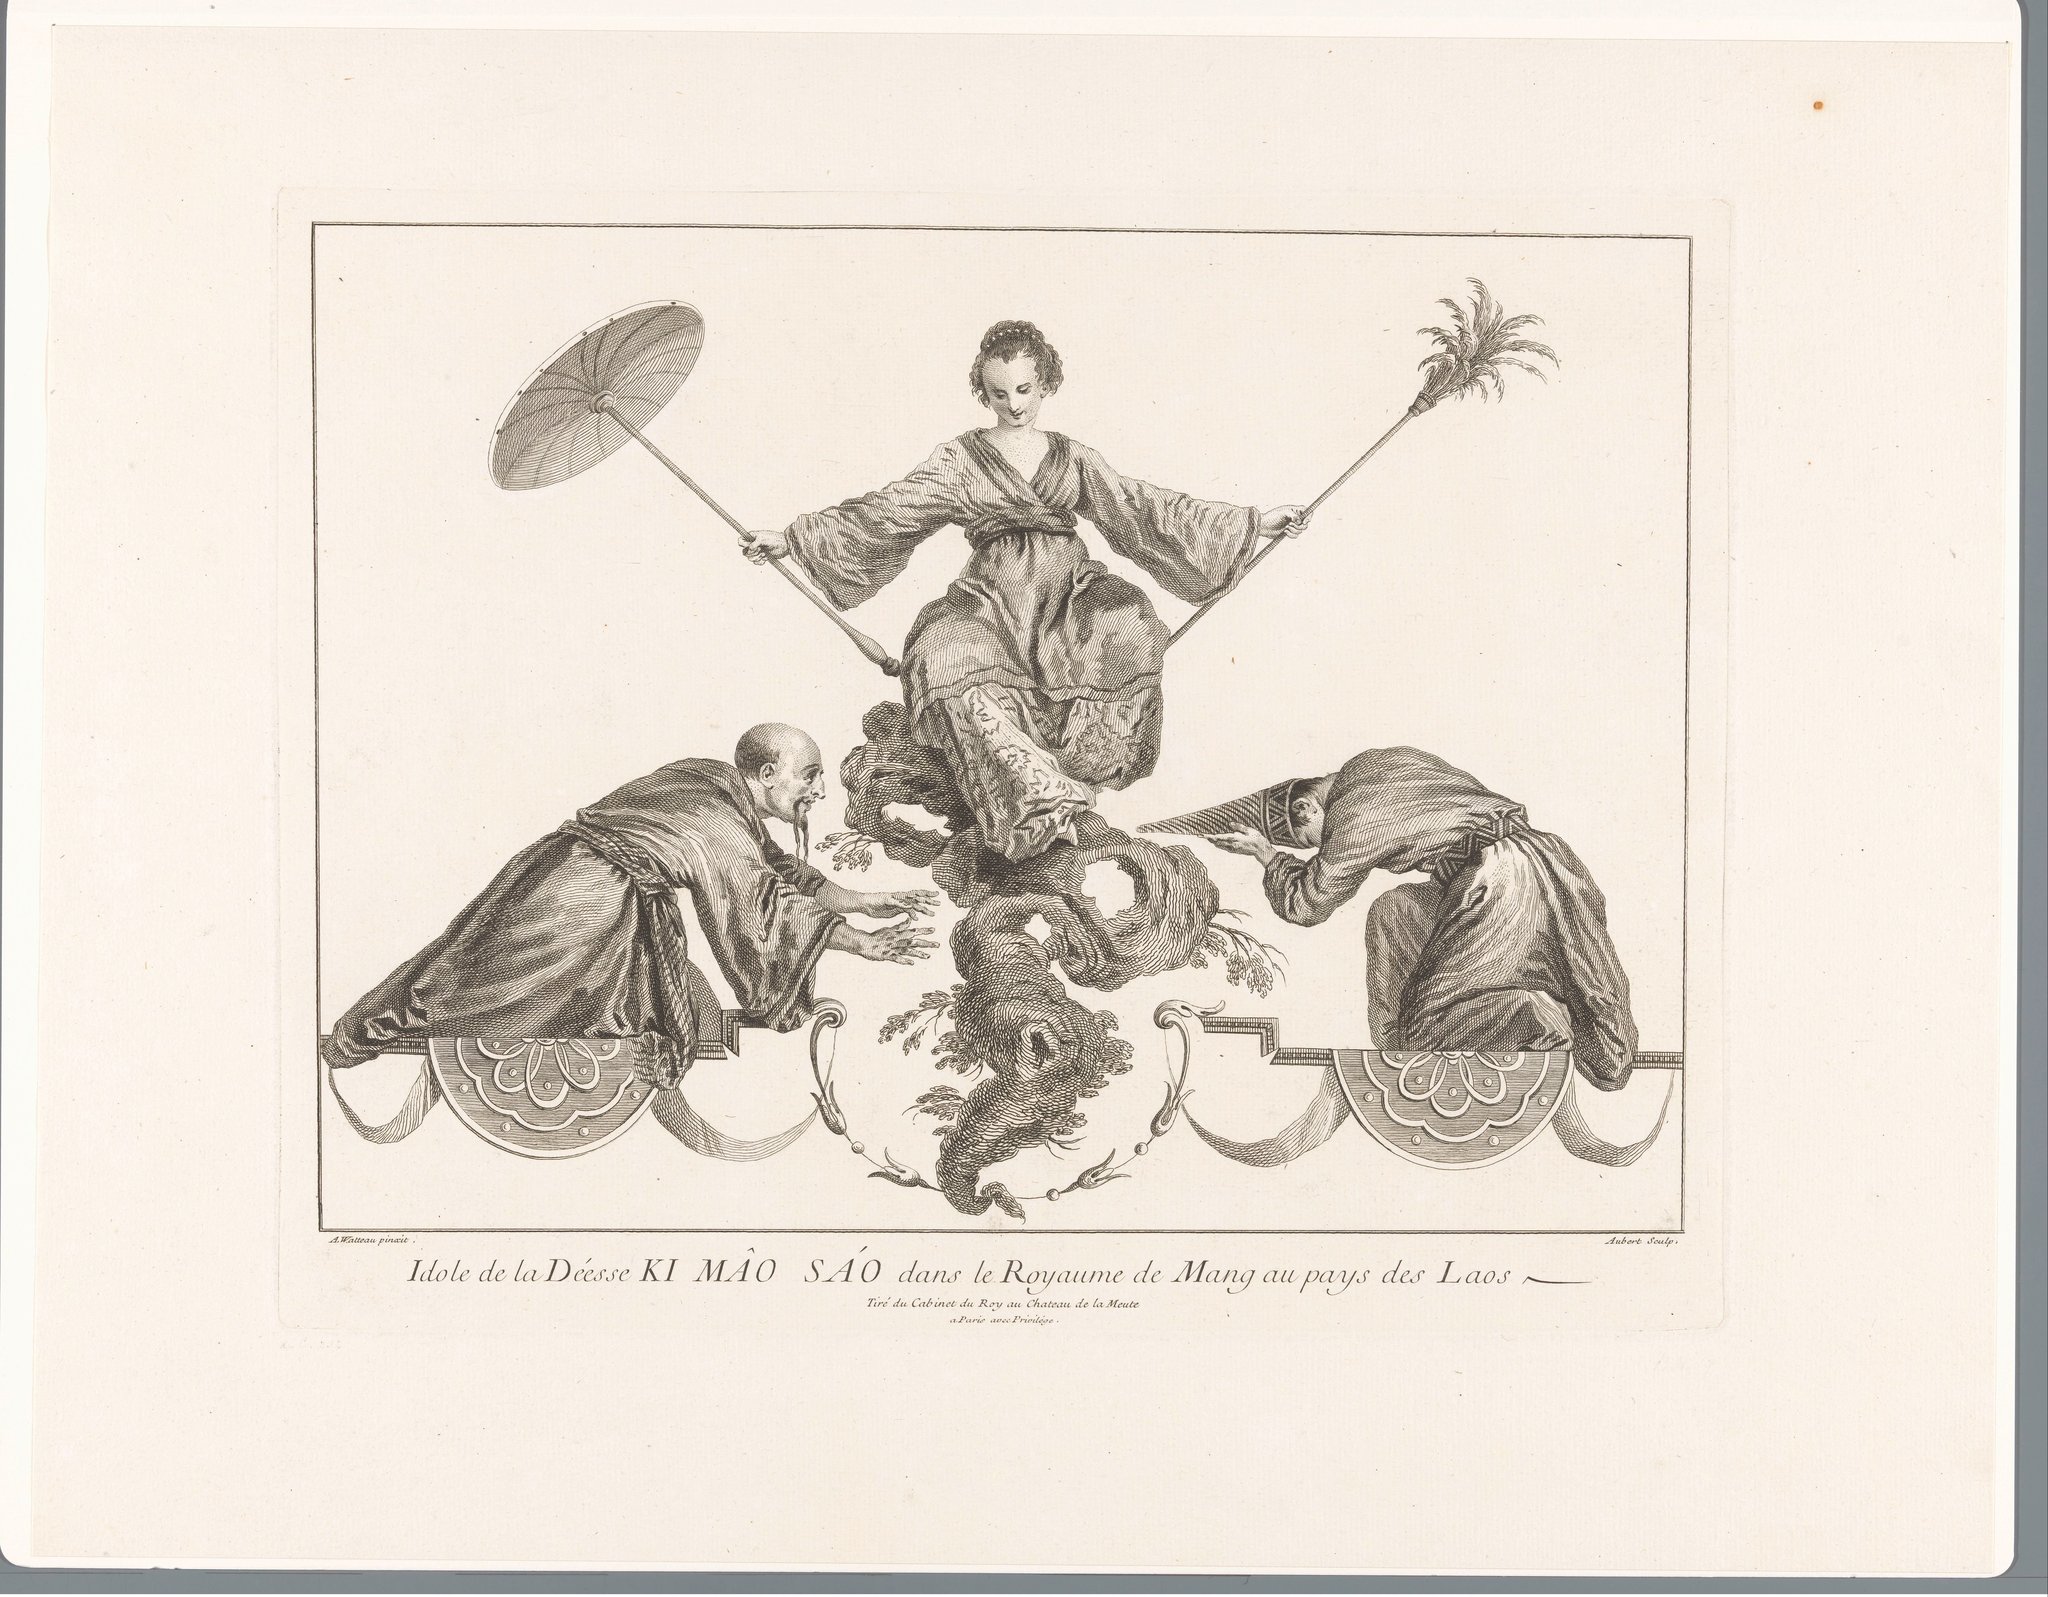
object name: print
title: Idole de la Déesse Ki Mâo Sáo dans le Royaume de Mang au pays de Laos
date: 1731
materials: paper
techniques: engraving, etching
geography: paris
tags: representations ~ goddesses, demi-goddesses, heroines, etc. (non-christian religions), kneeling figure, parasol, sunshade, laos